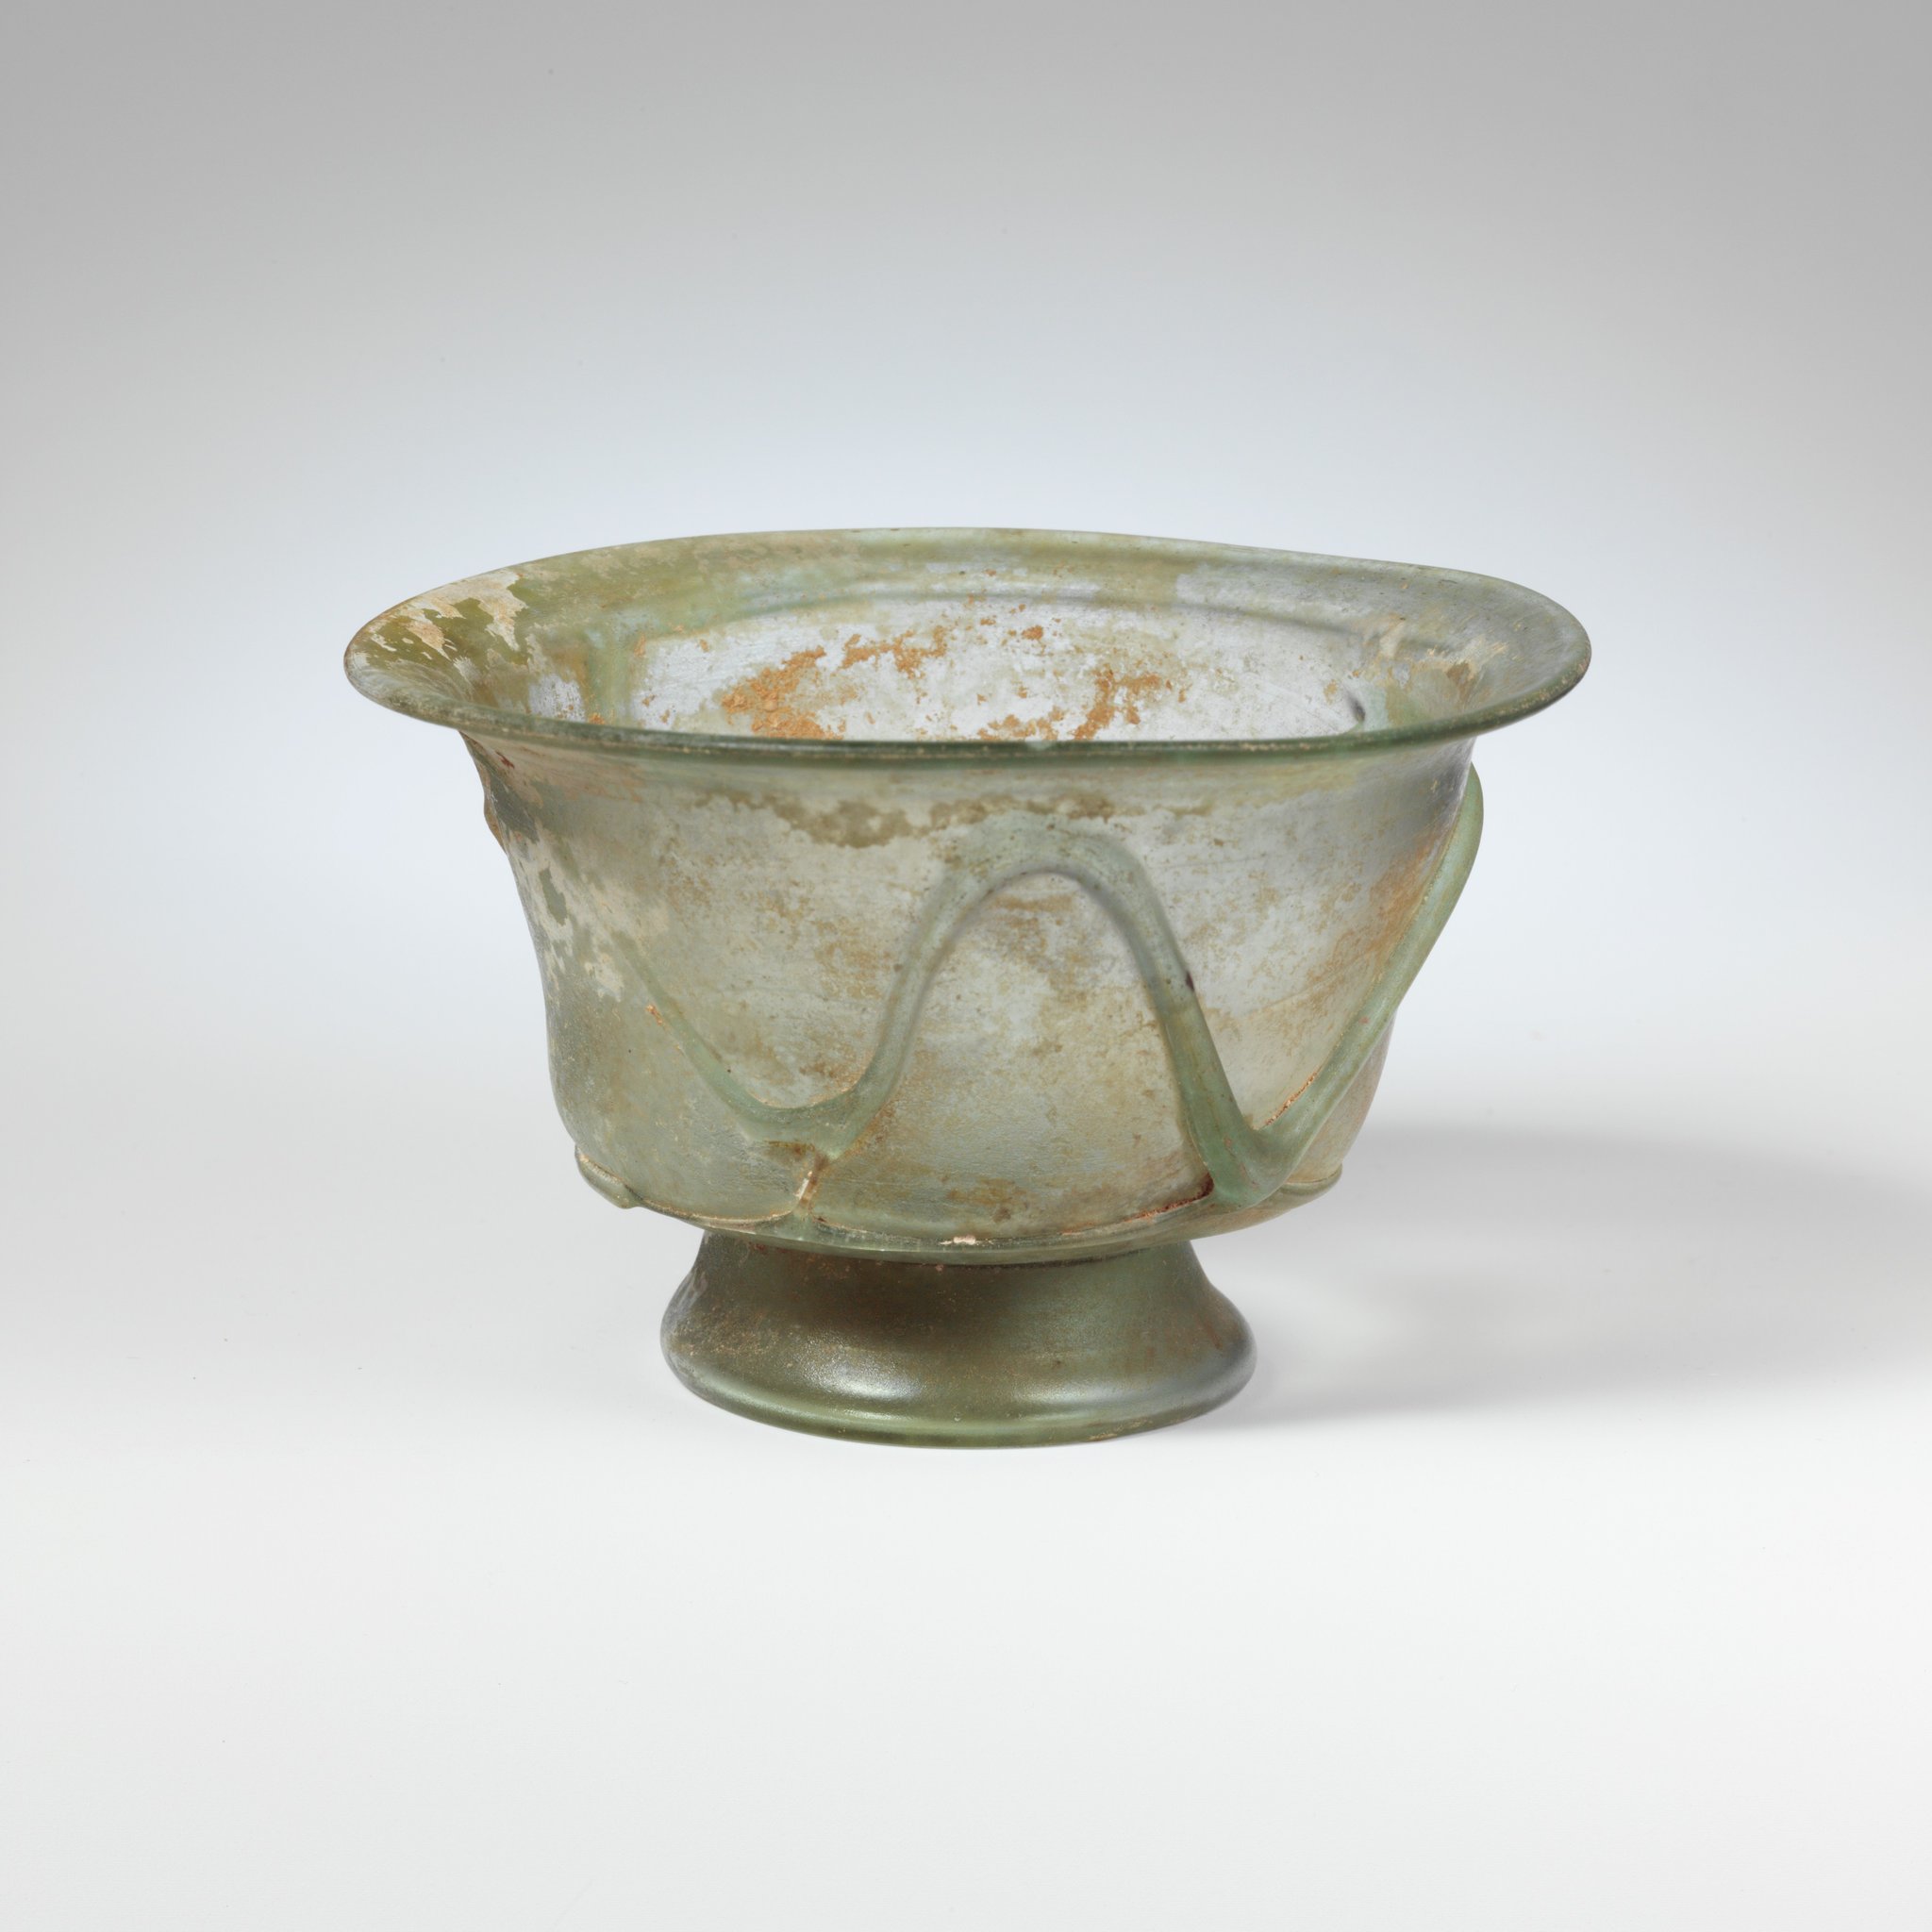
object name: bowl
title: Glass bowl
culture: roman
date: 301-400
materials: glass